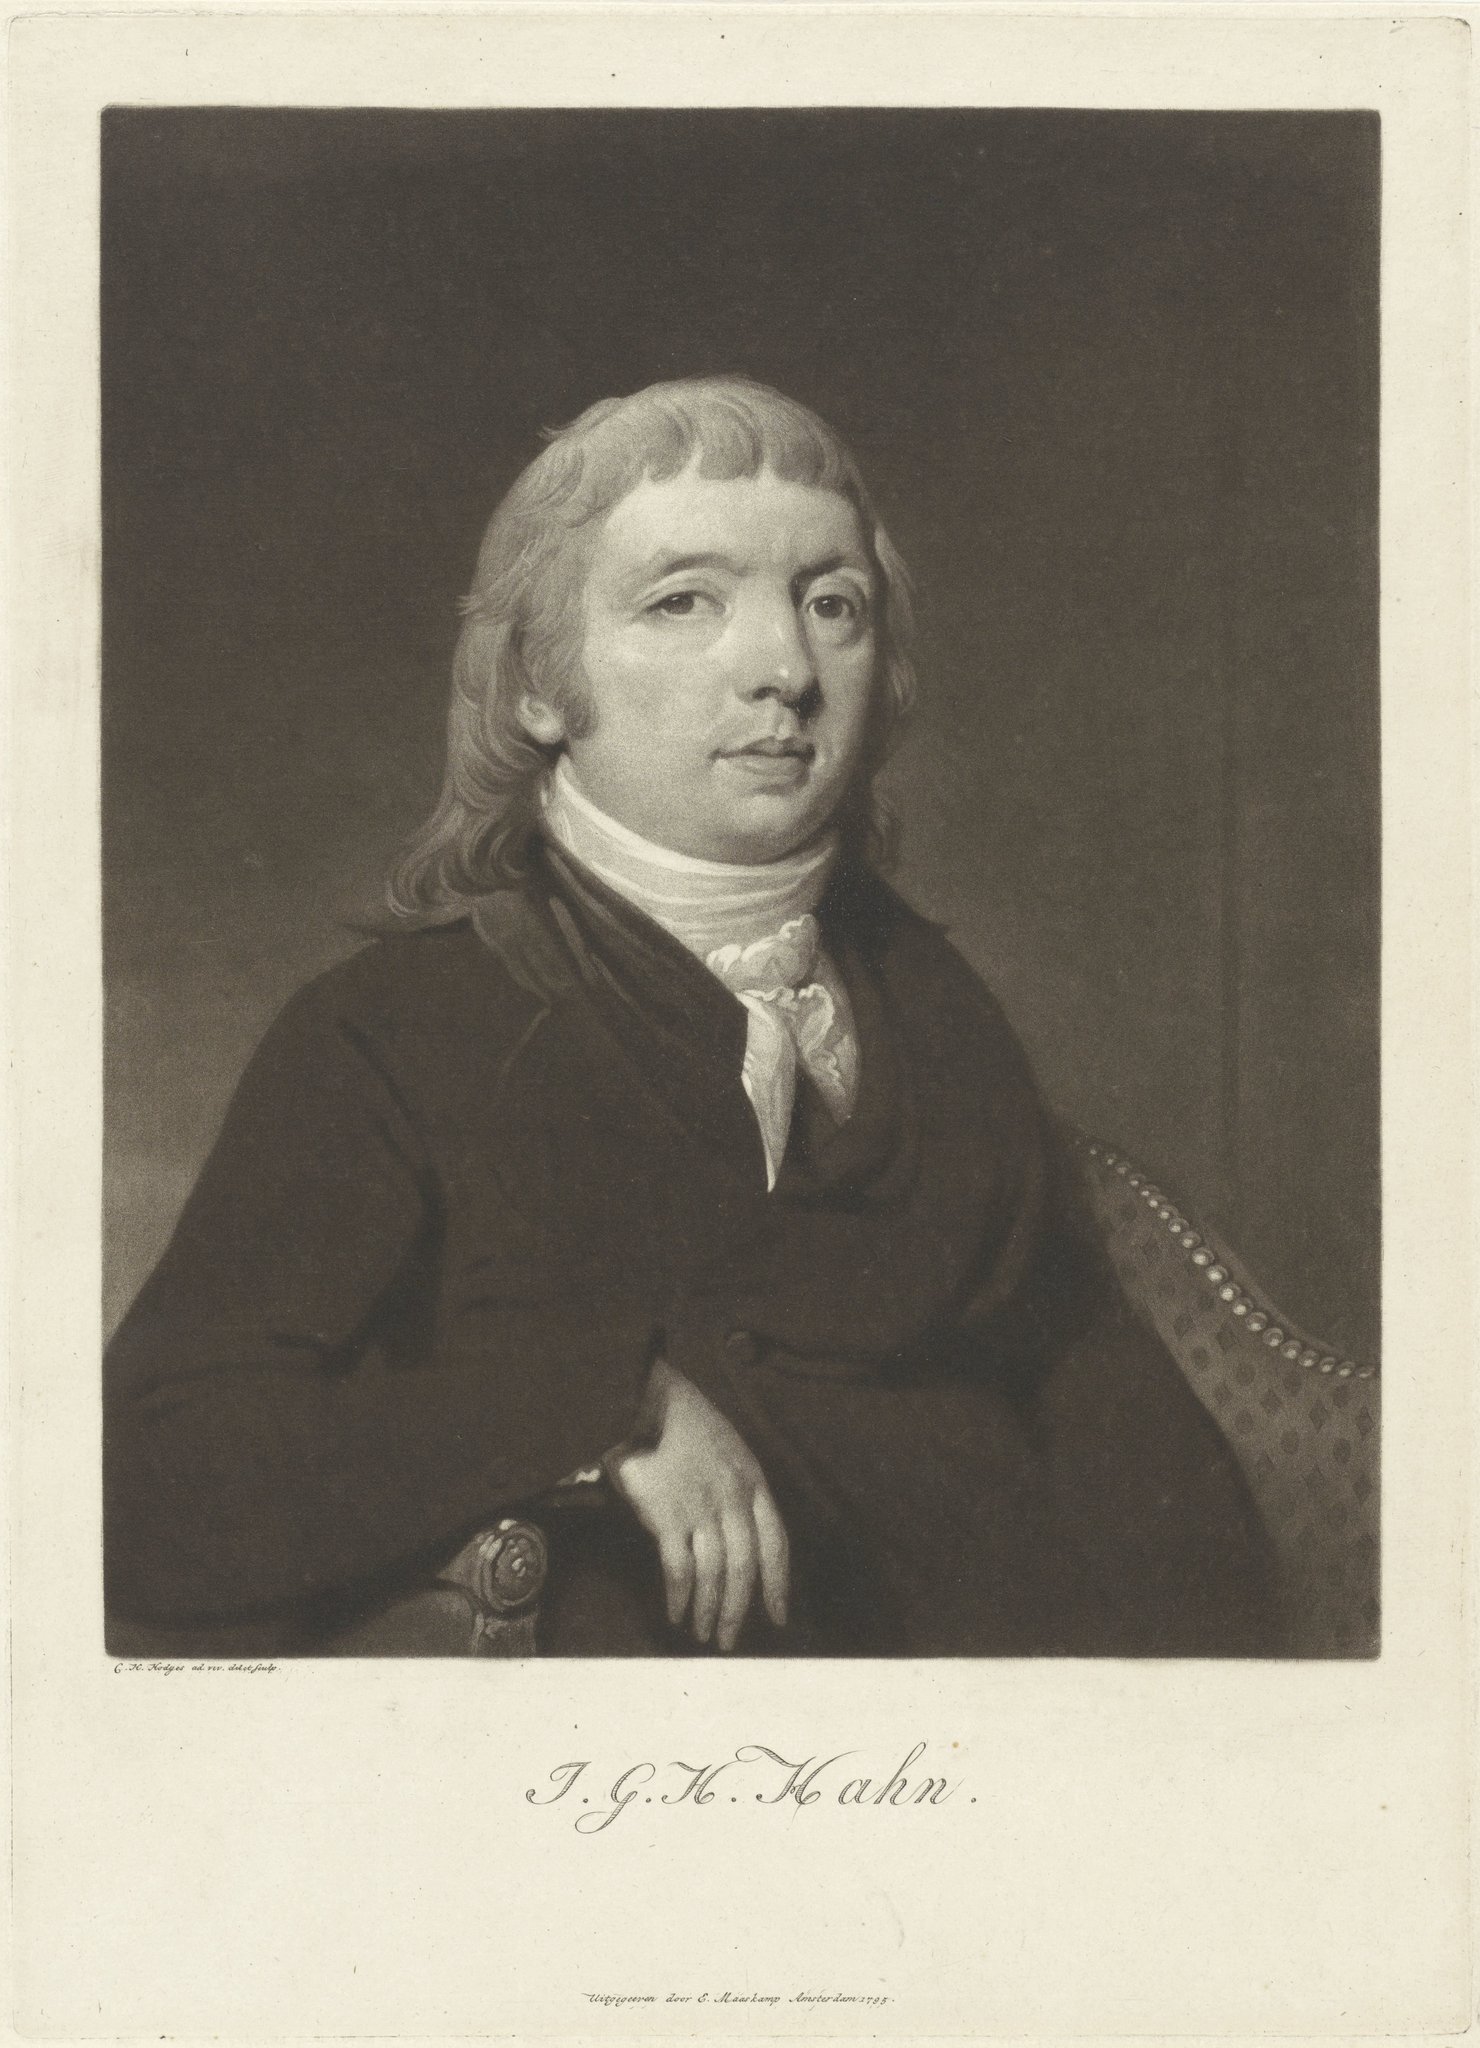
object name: print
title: Portret van Jacob George Jeronimo Hahn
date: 1795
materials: paper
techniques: engraving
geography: amsterdam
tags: haarlem, politician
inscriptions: collector's mark: Lugt 2228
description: De patriot en rechtsgeleerde Jacob George Jeronimo Hahn, zittend in een fauteuil.